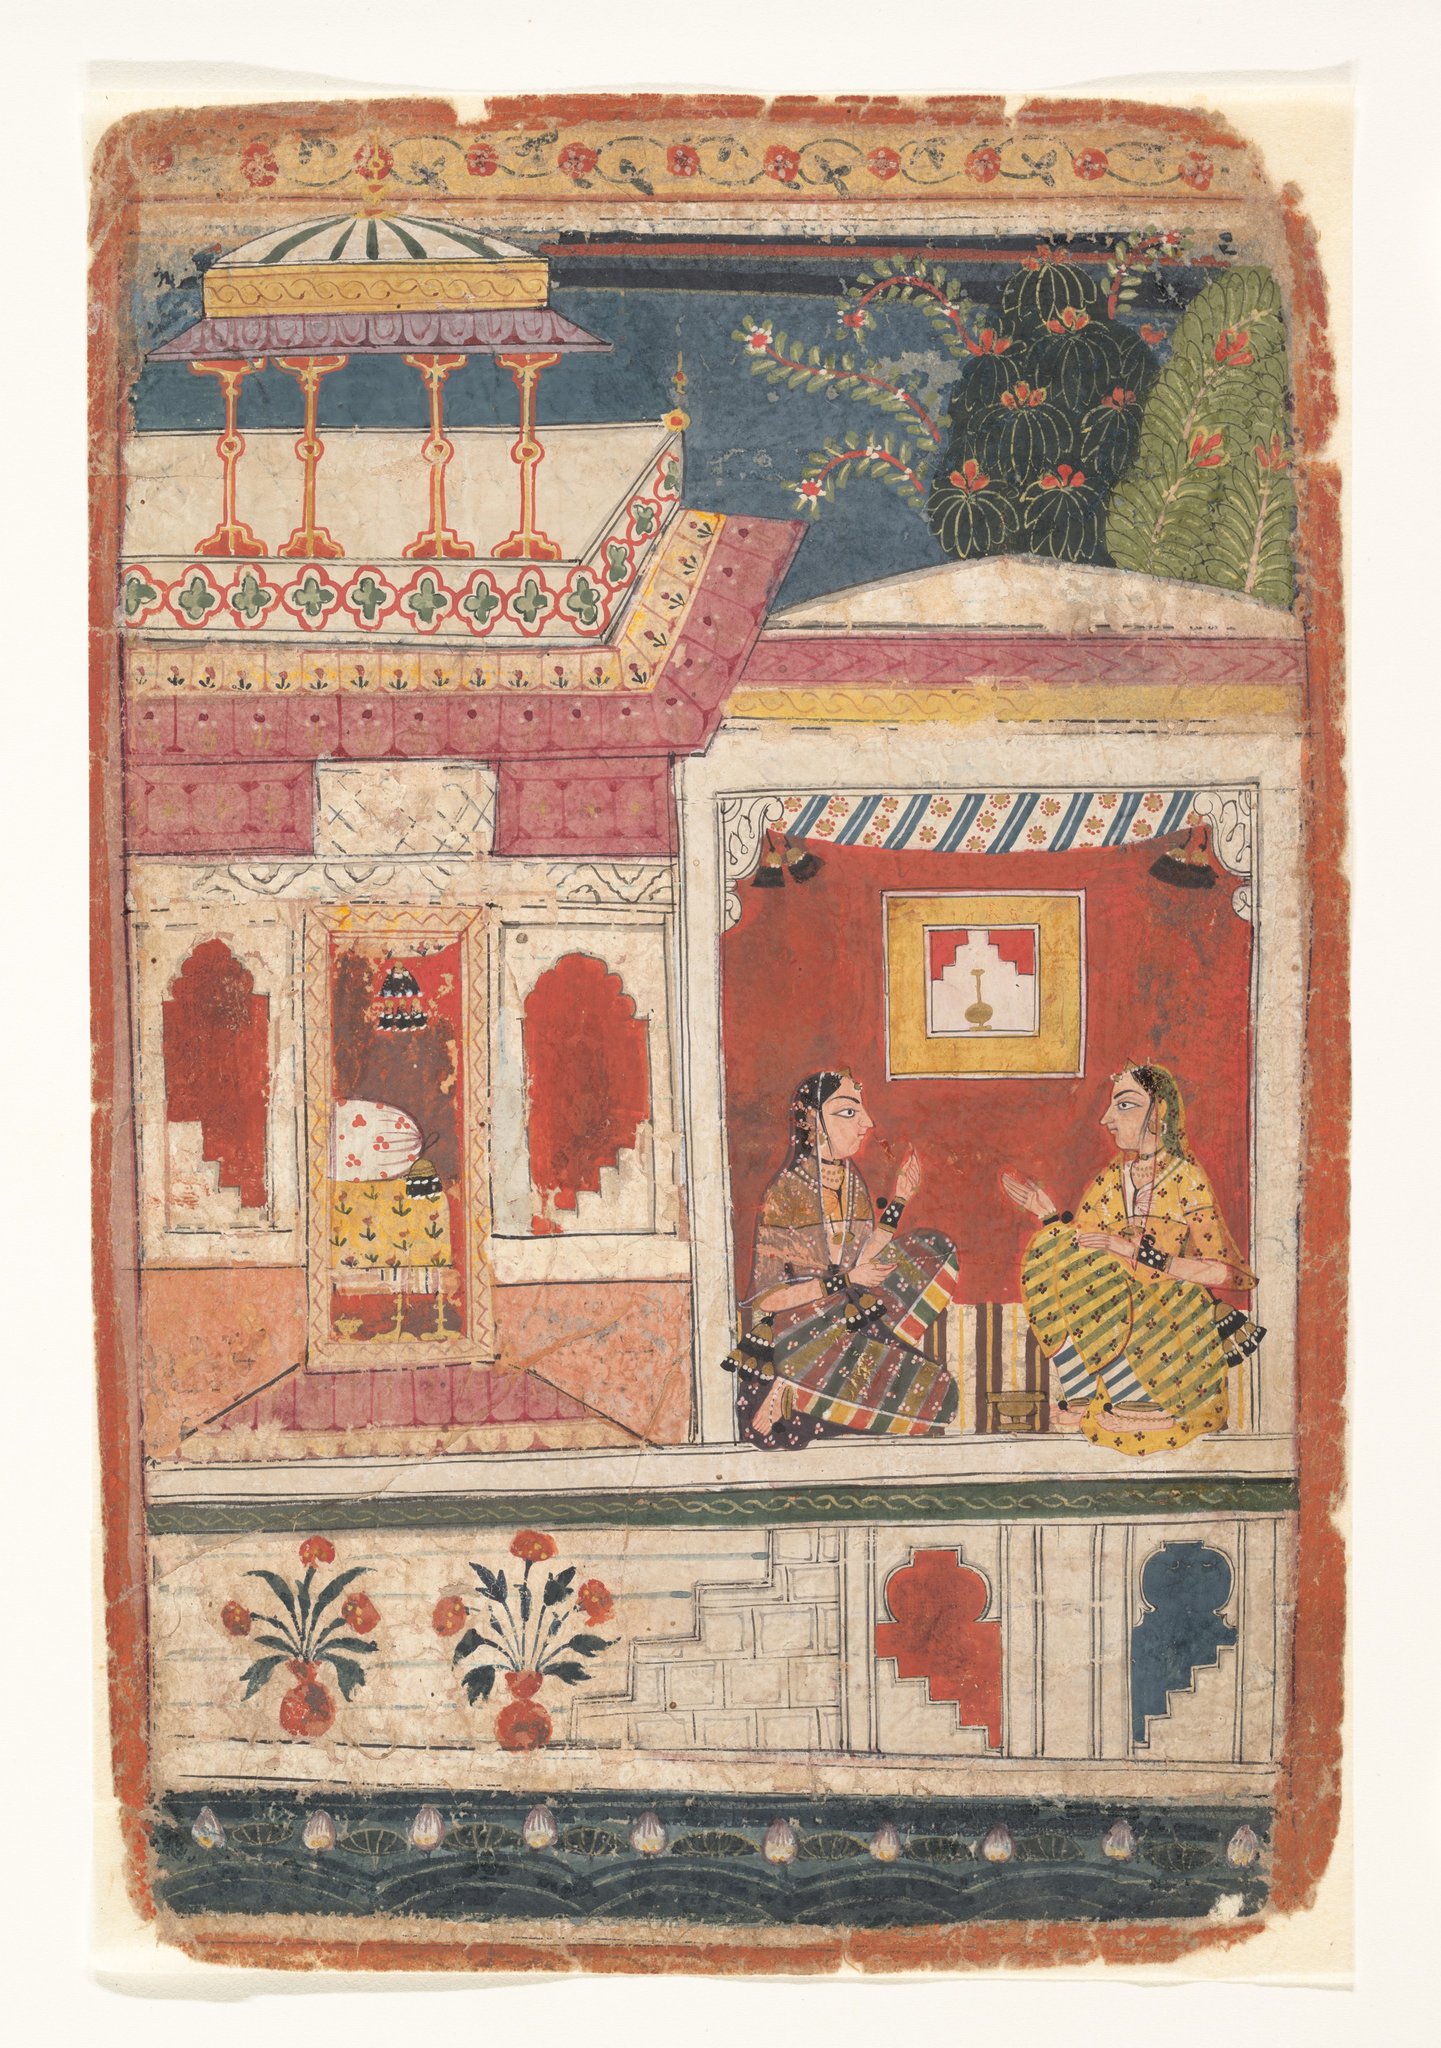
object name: folio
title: Radha and Her Confidant Sit in an Open Room: Page from a Dispersed Rasikapriya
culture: indian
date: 1680-1690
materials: ink, paper, watercolor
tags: buildings,women,radha